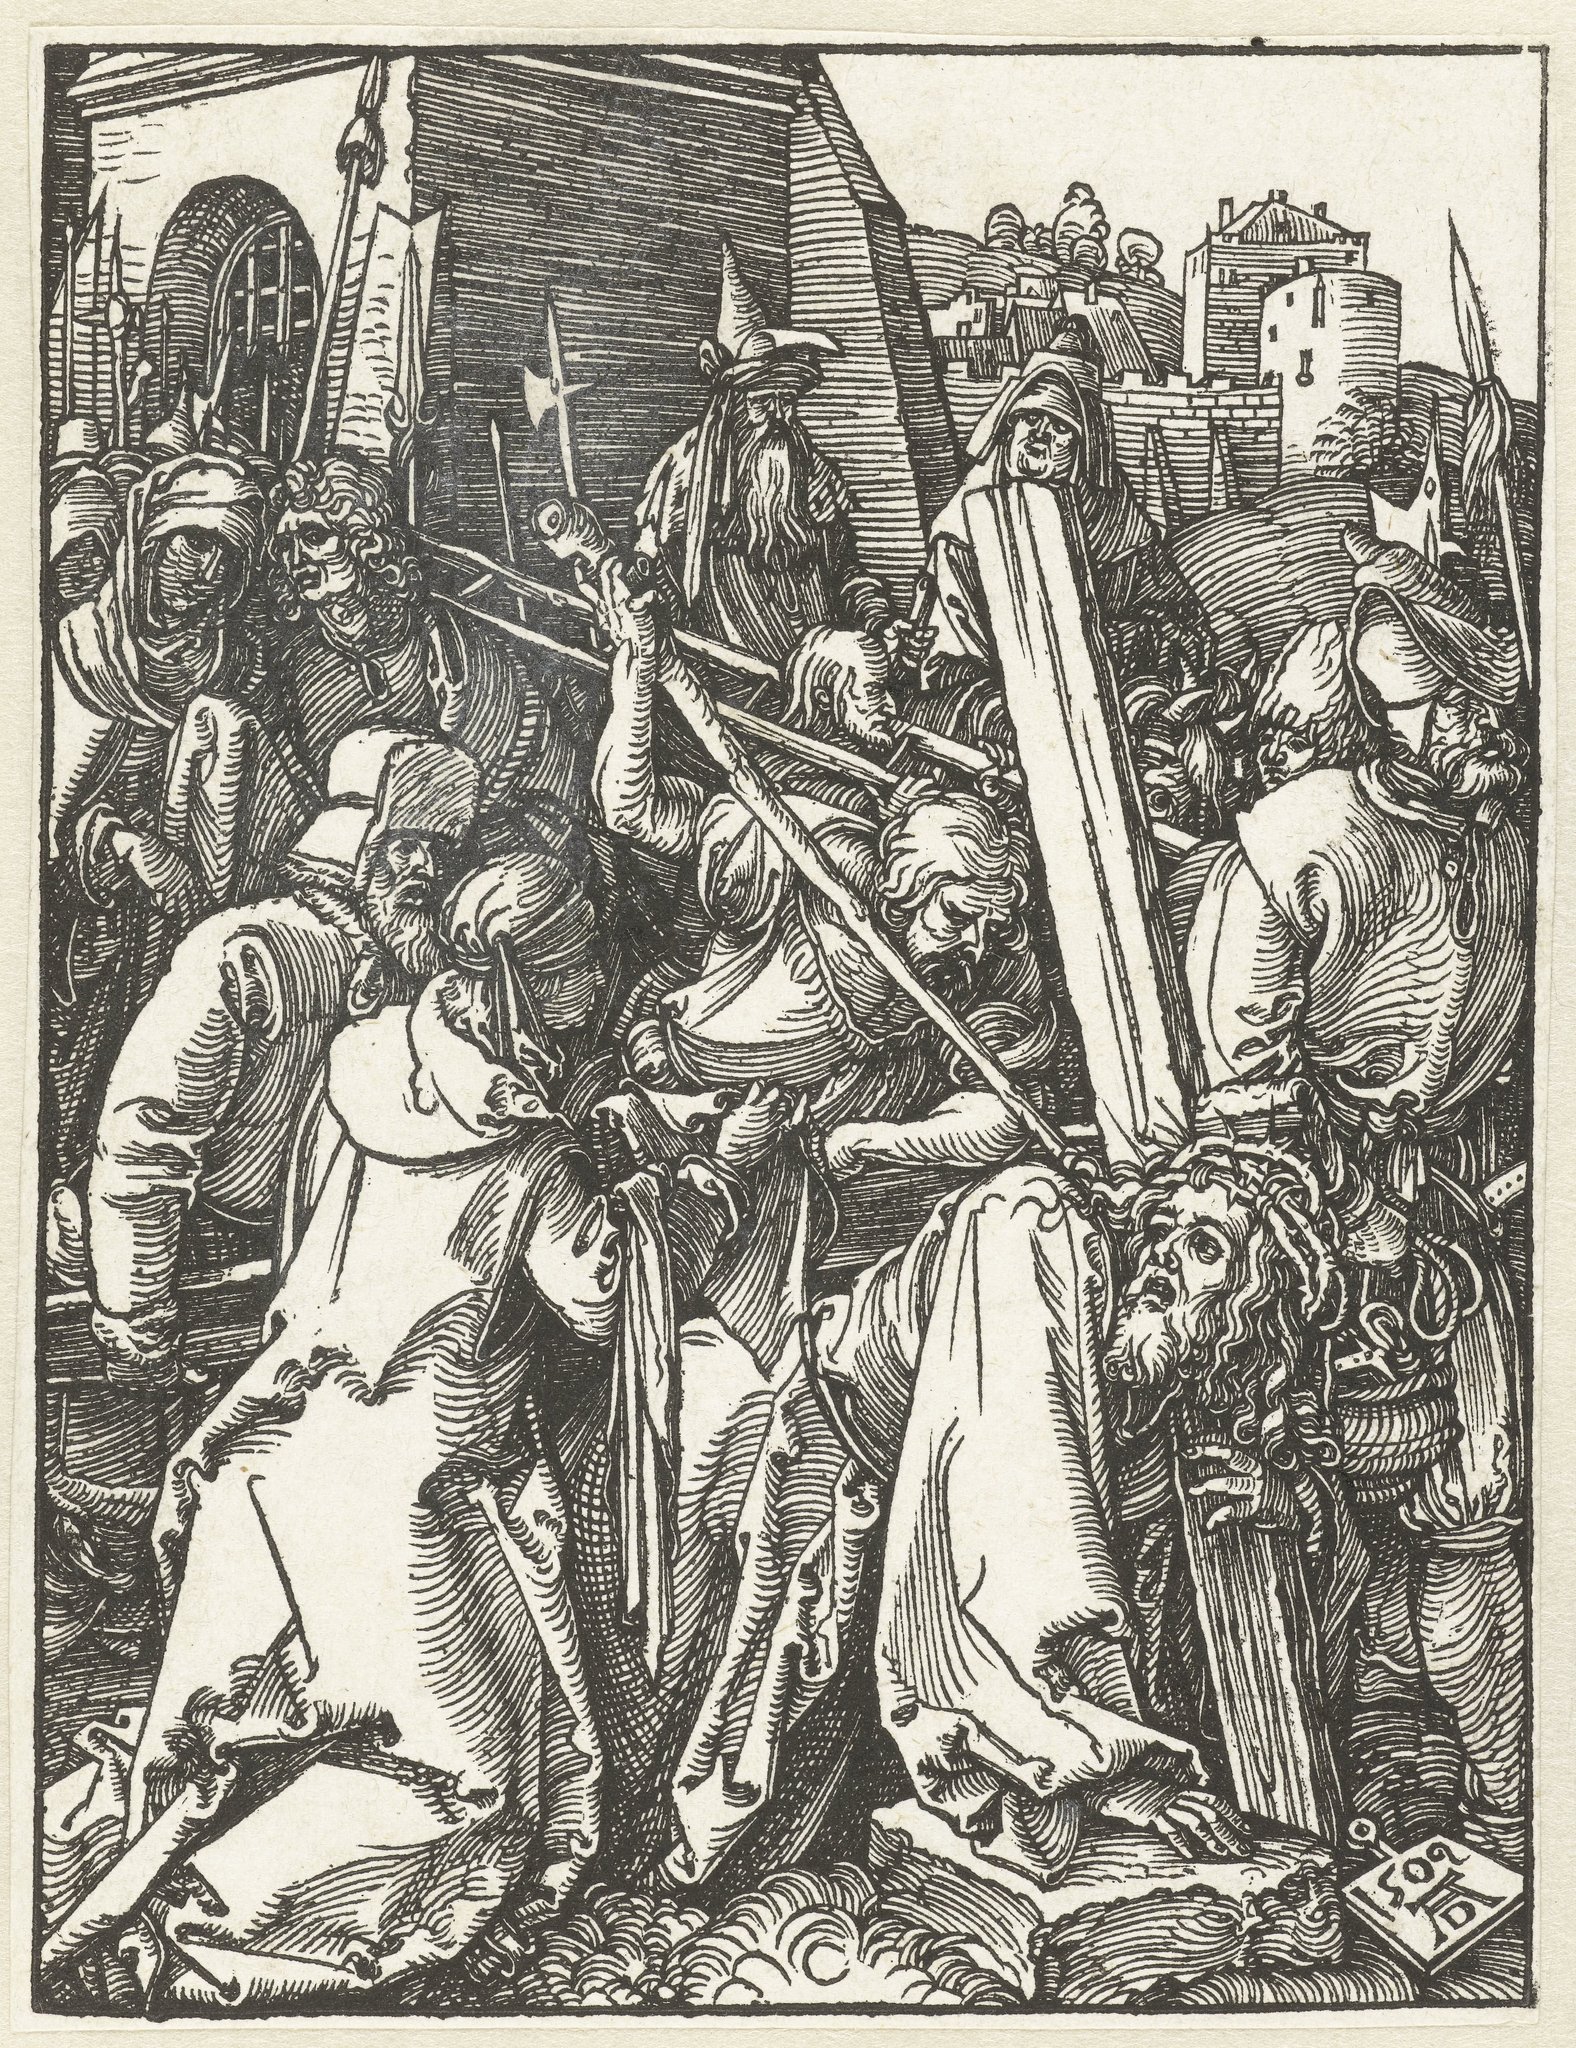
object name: print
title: Kruisdraging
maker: albrecht dürer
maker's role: draughtsman, painter, print maker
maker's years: 1471-1528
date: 1509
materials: paper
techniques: woodcut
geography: nuremberg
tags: christ meets veronica, who has a cloth to wipe christ's face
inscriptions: collector's mark: Lugt 2228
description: Christus draagt zijn kruis, gevolgd door een menigte mensen; Veronica staat met de zweetdoek naast hem. Deze prent is onderdeel van de prentserie 'De kleine Passie', bestaande uit een titelprent en 36 bijbelse scènes (voornamelijk uit het Lijdensverhaal).